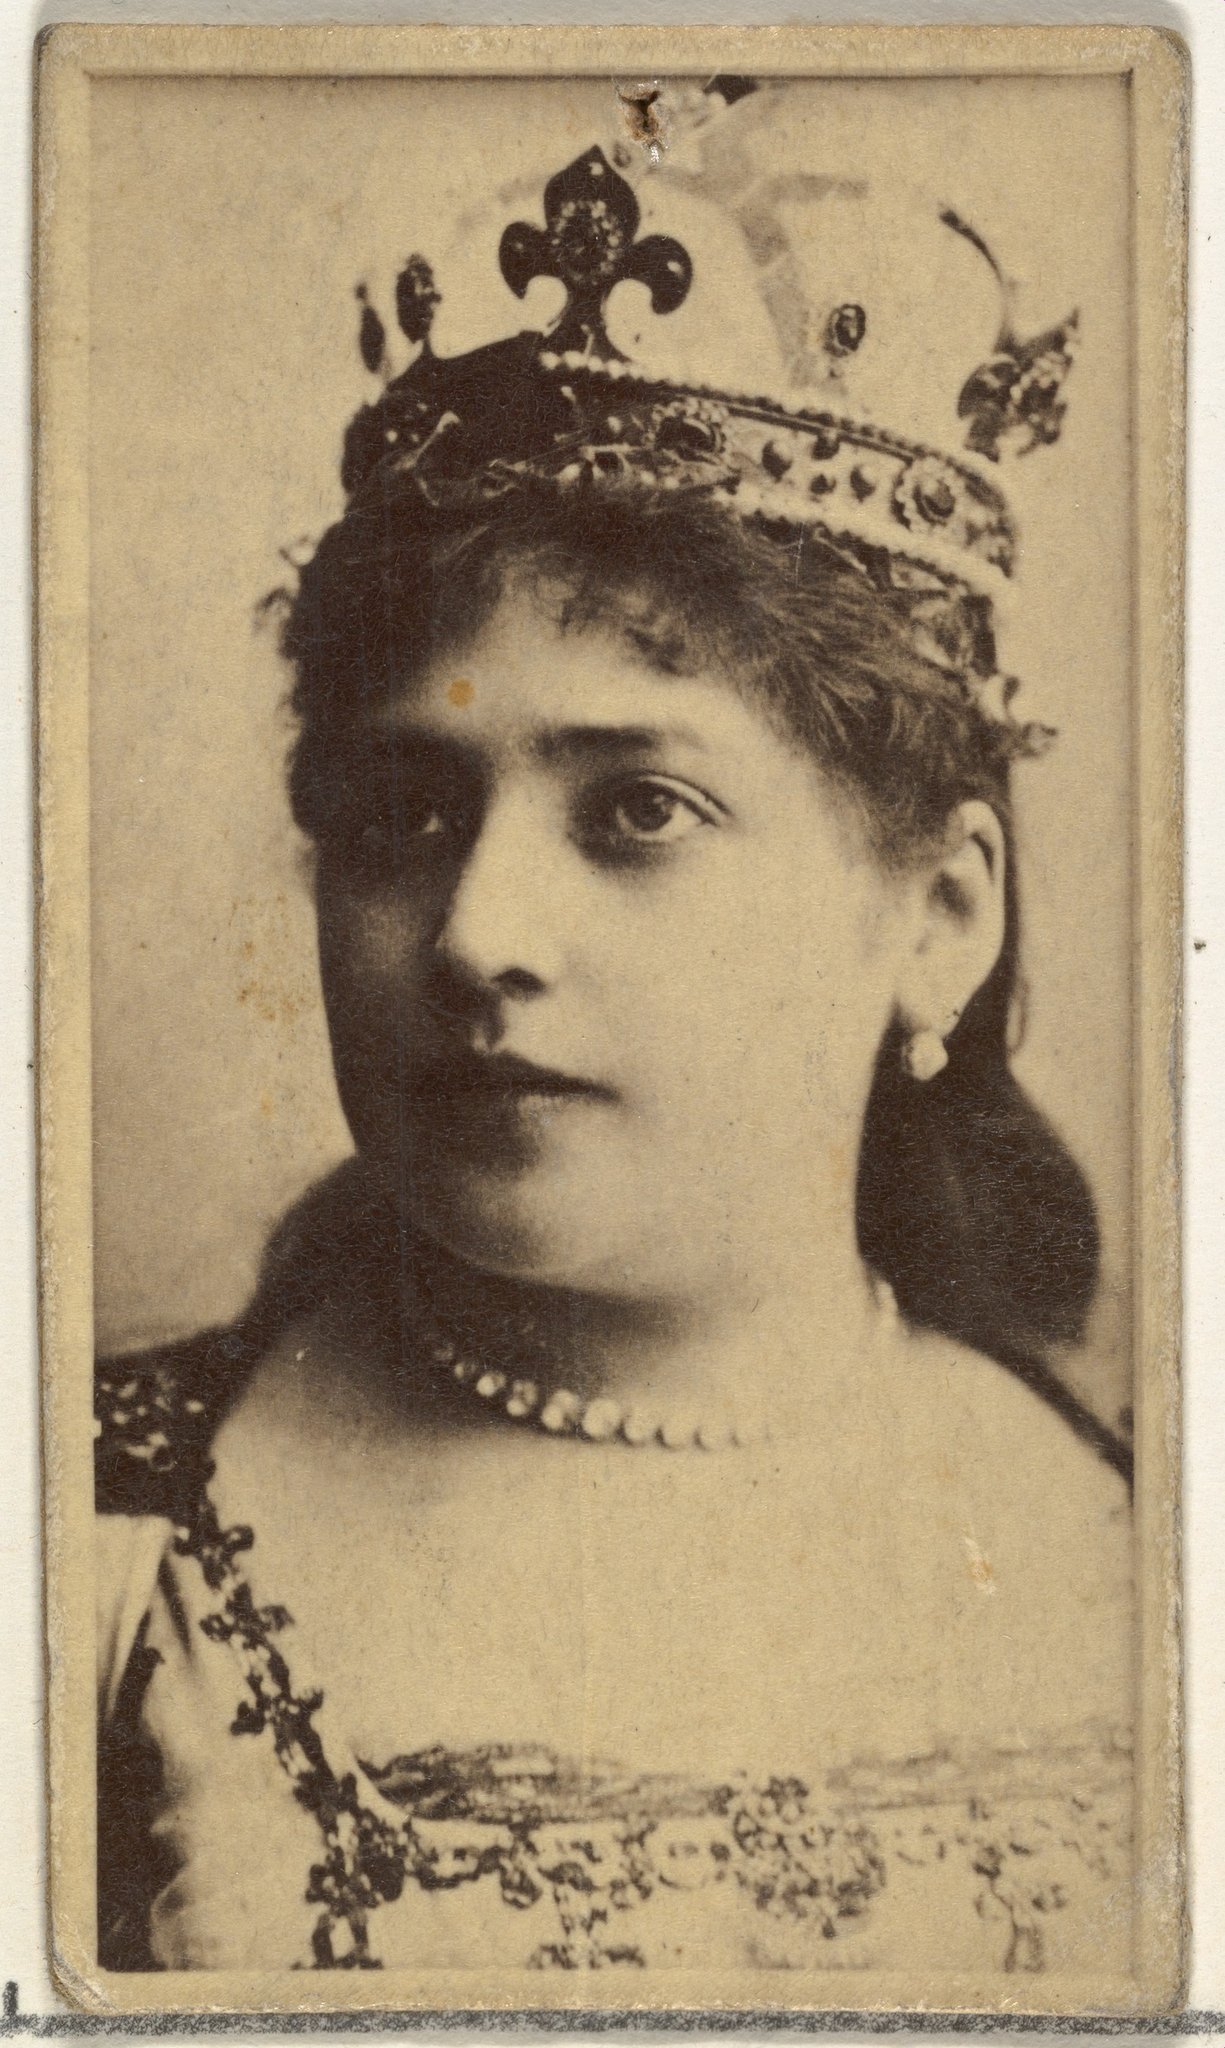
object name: photograph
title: [Actress wearing crown], from the Actors and Actresses series (N145-8) issued by Duke Sons & Co. to promote Duke Cigarettes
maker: w. duke, sons & co.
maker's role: publisher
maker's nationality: american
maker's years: 1870-1920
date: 1891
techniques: albumen silver print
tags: portraits,women,actresses